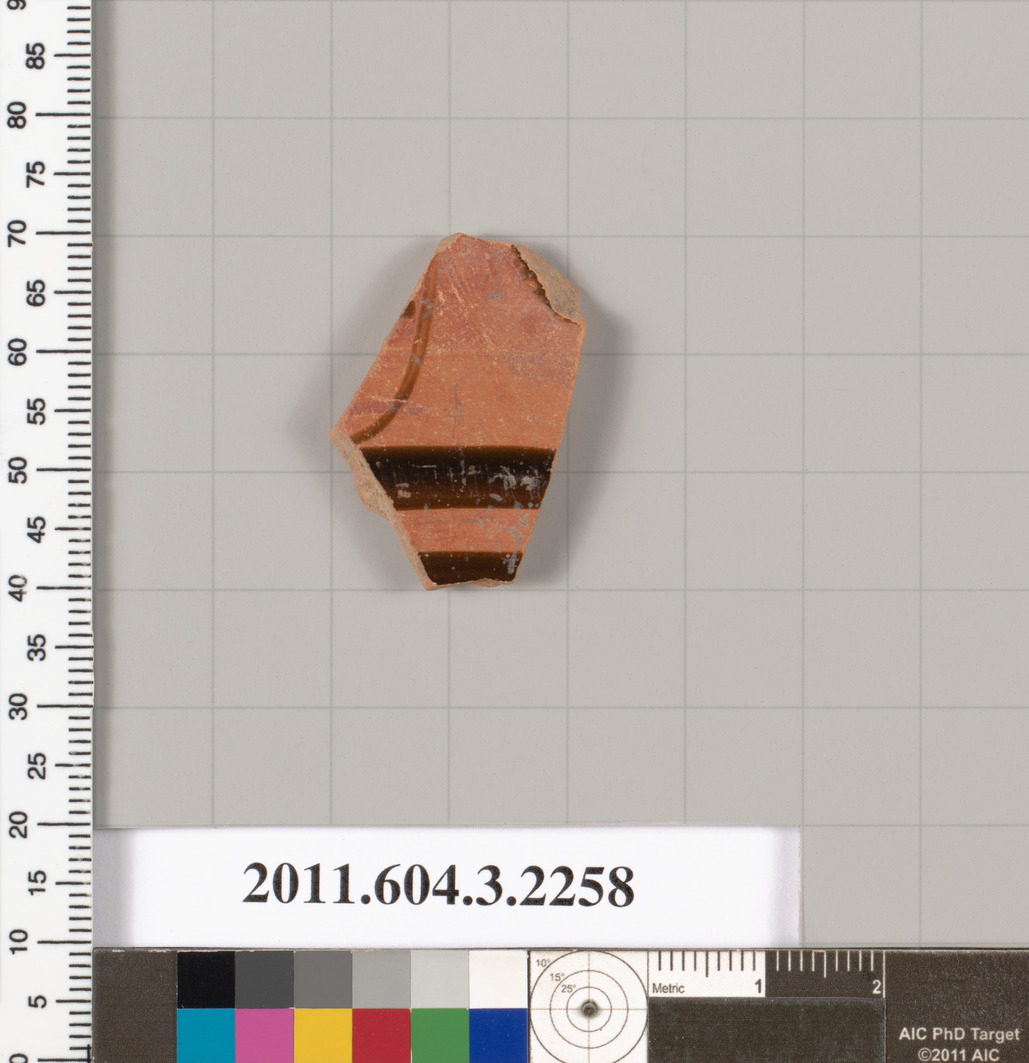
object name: kylix fragment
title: Terracotta fragment of a kylix (drinking cup)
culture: greek, attic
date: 600-401 BCE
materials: terracotta